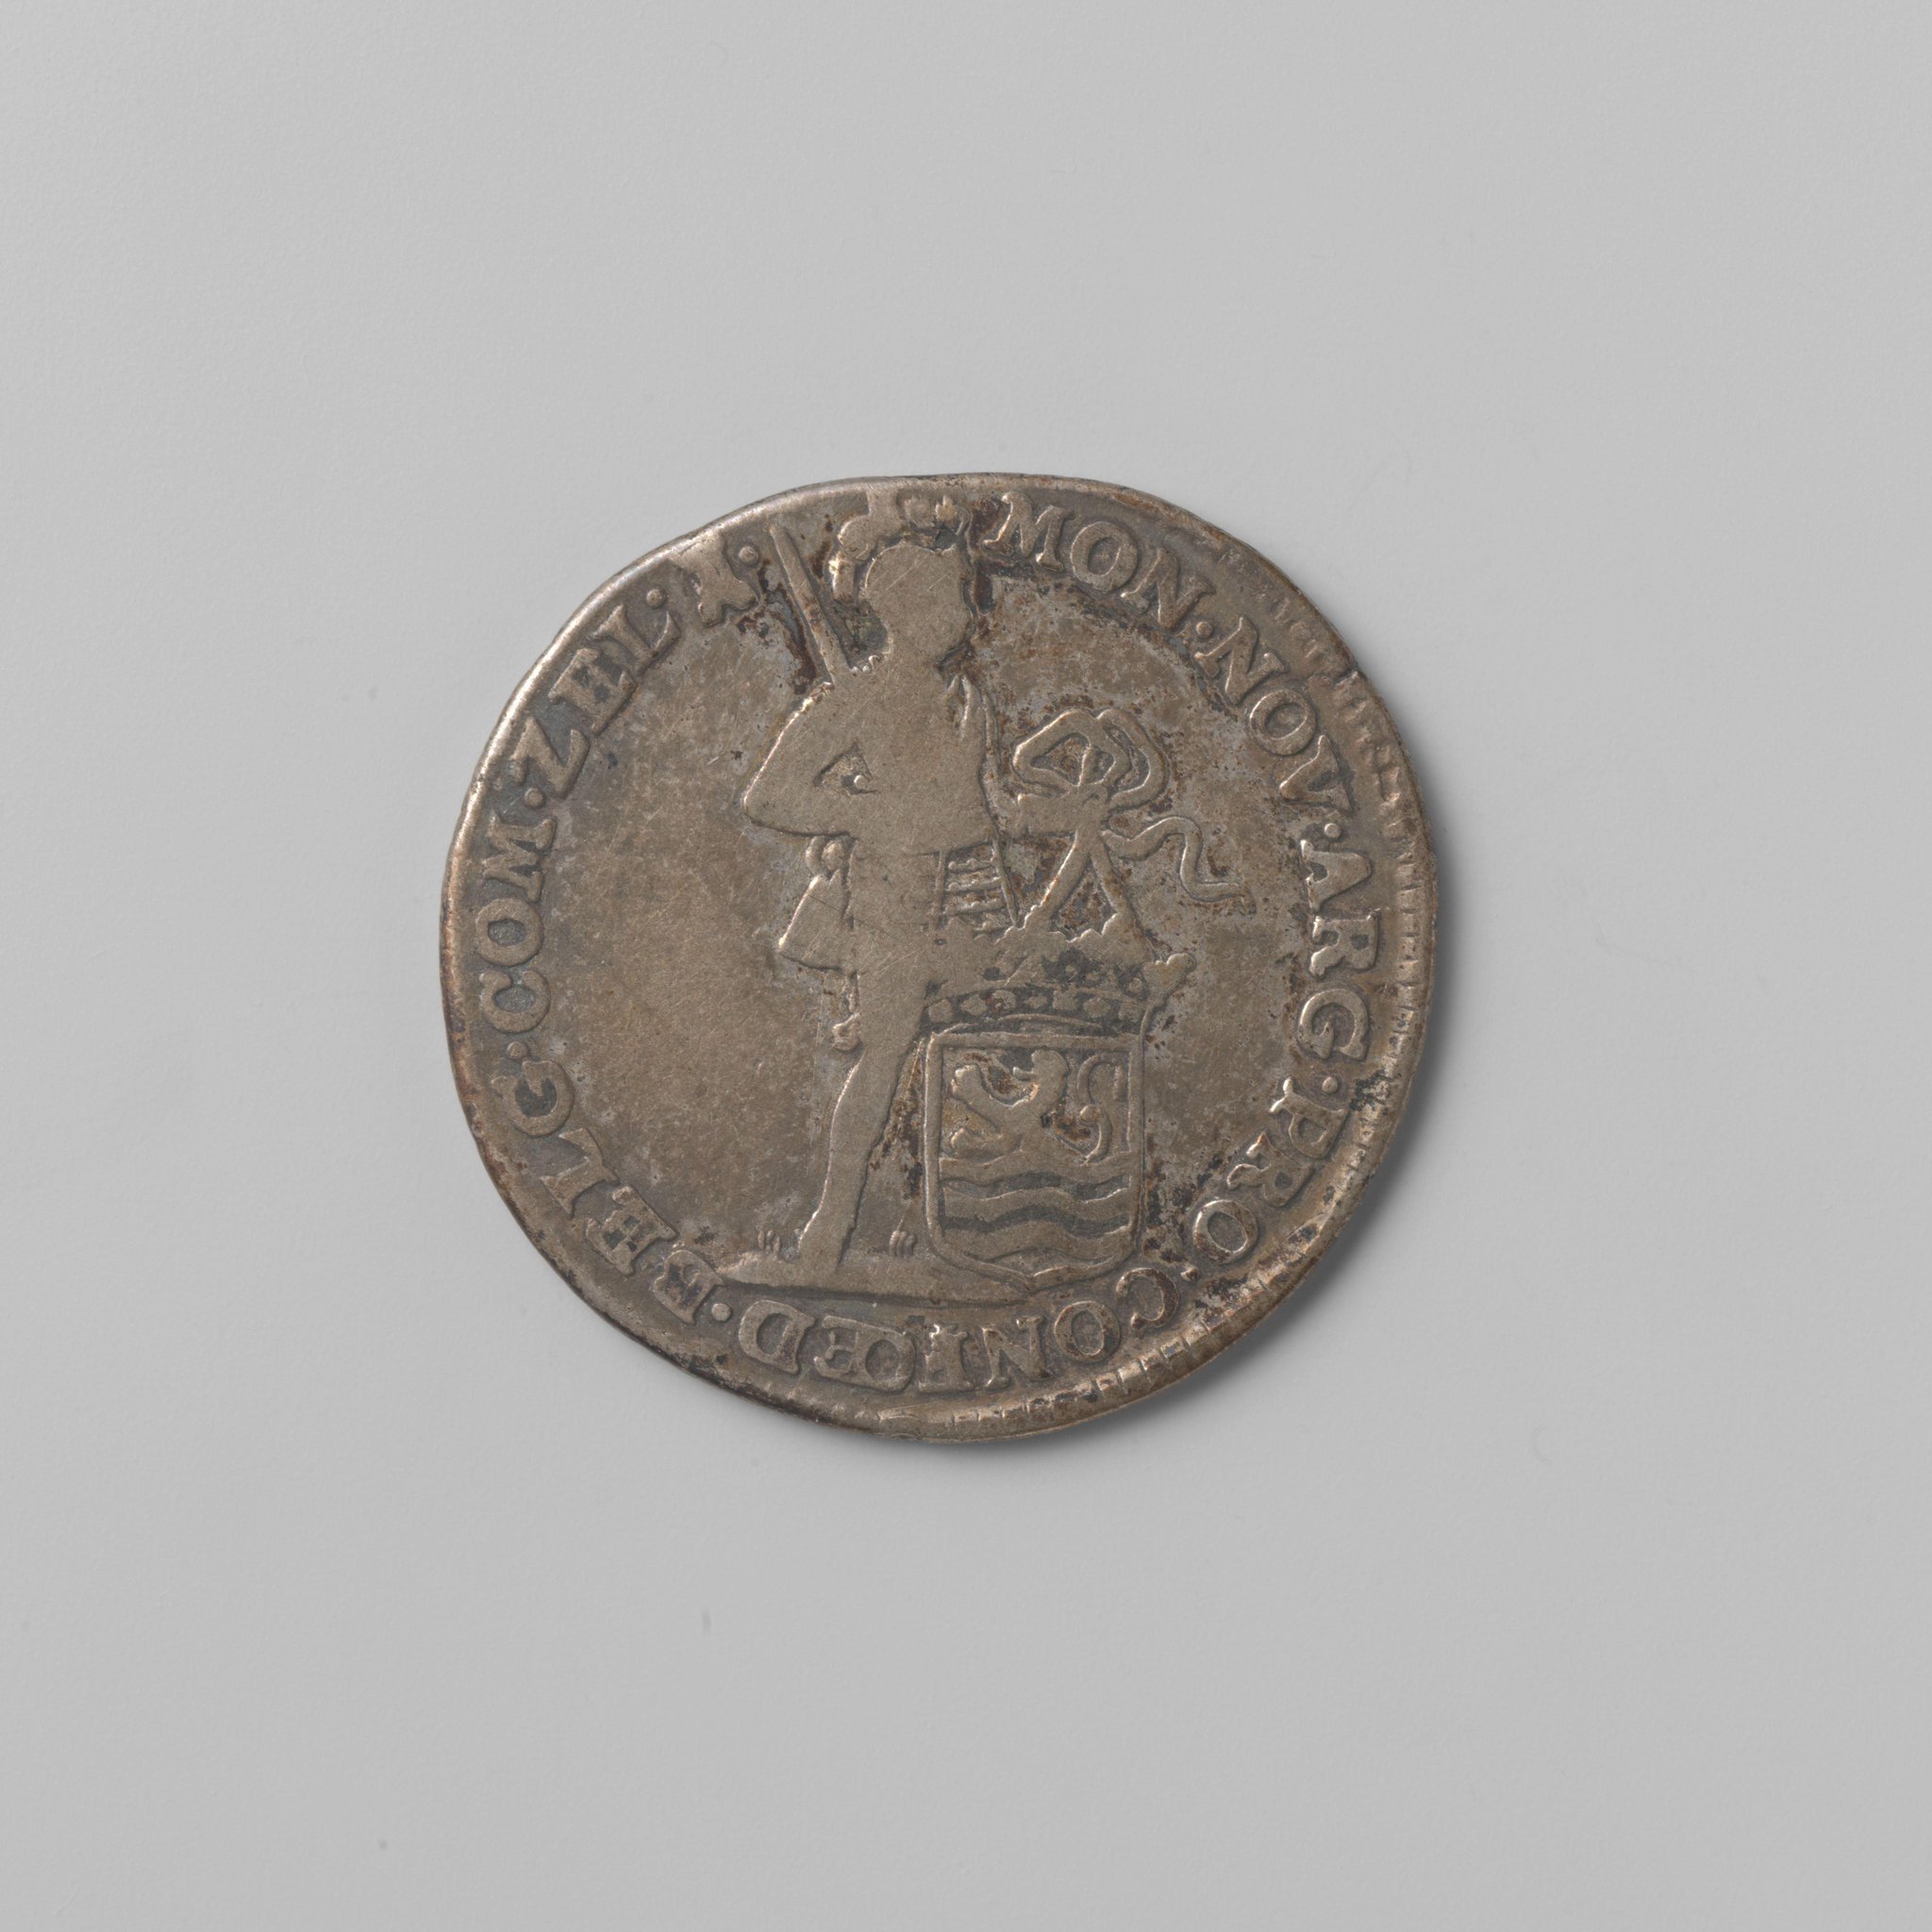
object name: coin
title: Zeeland, halve zilveren dukaat, 1762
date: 1762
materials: silver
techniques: striking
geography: middelburg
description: Zilveren munt. Voorzijde: staande geharnaste ridder naar rechts met zwaard in rechterhand en gekroond wapenschild van Zeeland aan lint in linkerhand. Keerzijde: tussen jaartal gekroond generaliteitswapenschild. Kabelrand.